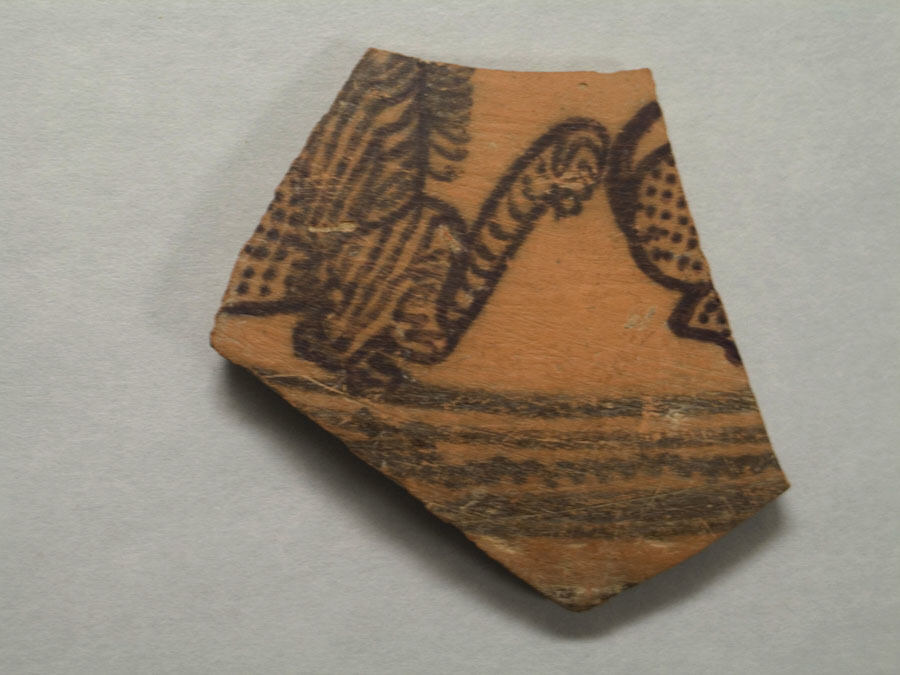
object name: shard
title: Shard: Forepaws of Carnivore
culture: pakistani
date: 301-500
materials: terracotta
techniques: painting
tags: gandhara